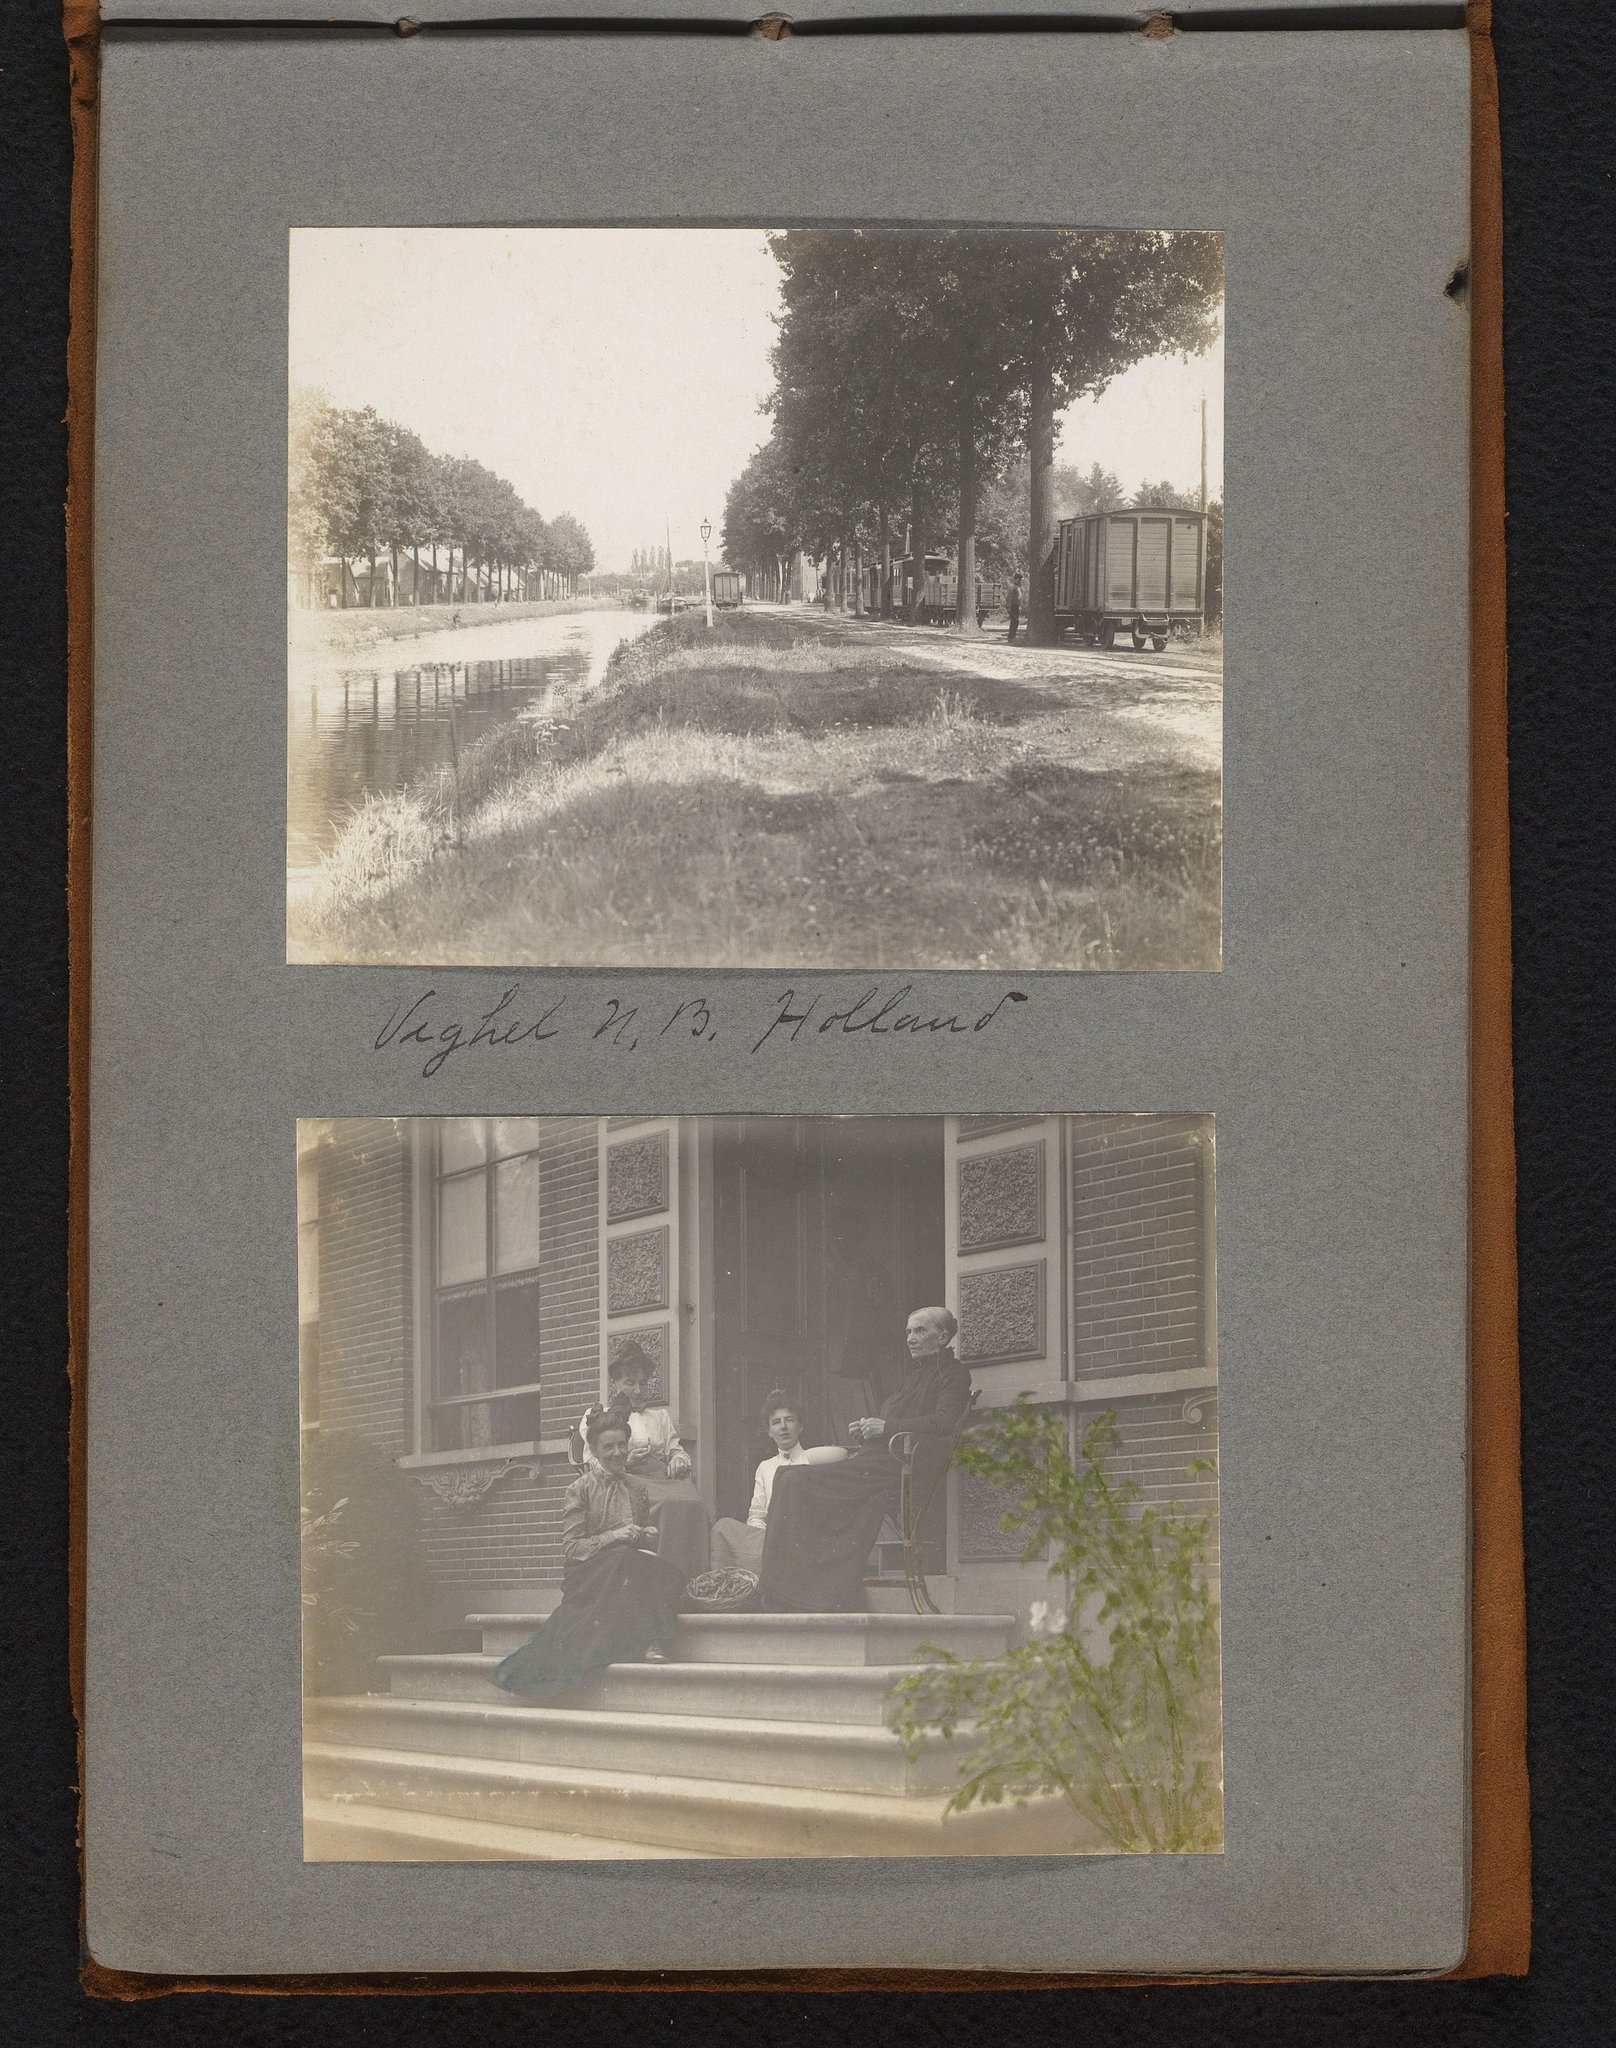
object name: photograph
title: Veghel N.B. Holland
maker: jan van der mey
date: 1902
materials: paper, paint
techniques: gelatin silver print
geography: veghel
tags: historical persons not known by name - bb - woman, railway wagon, canal, front steps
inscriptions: inscription: ‘Veghel N.B. Holland’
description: Deze foto's maken deel uit van een album.